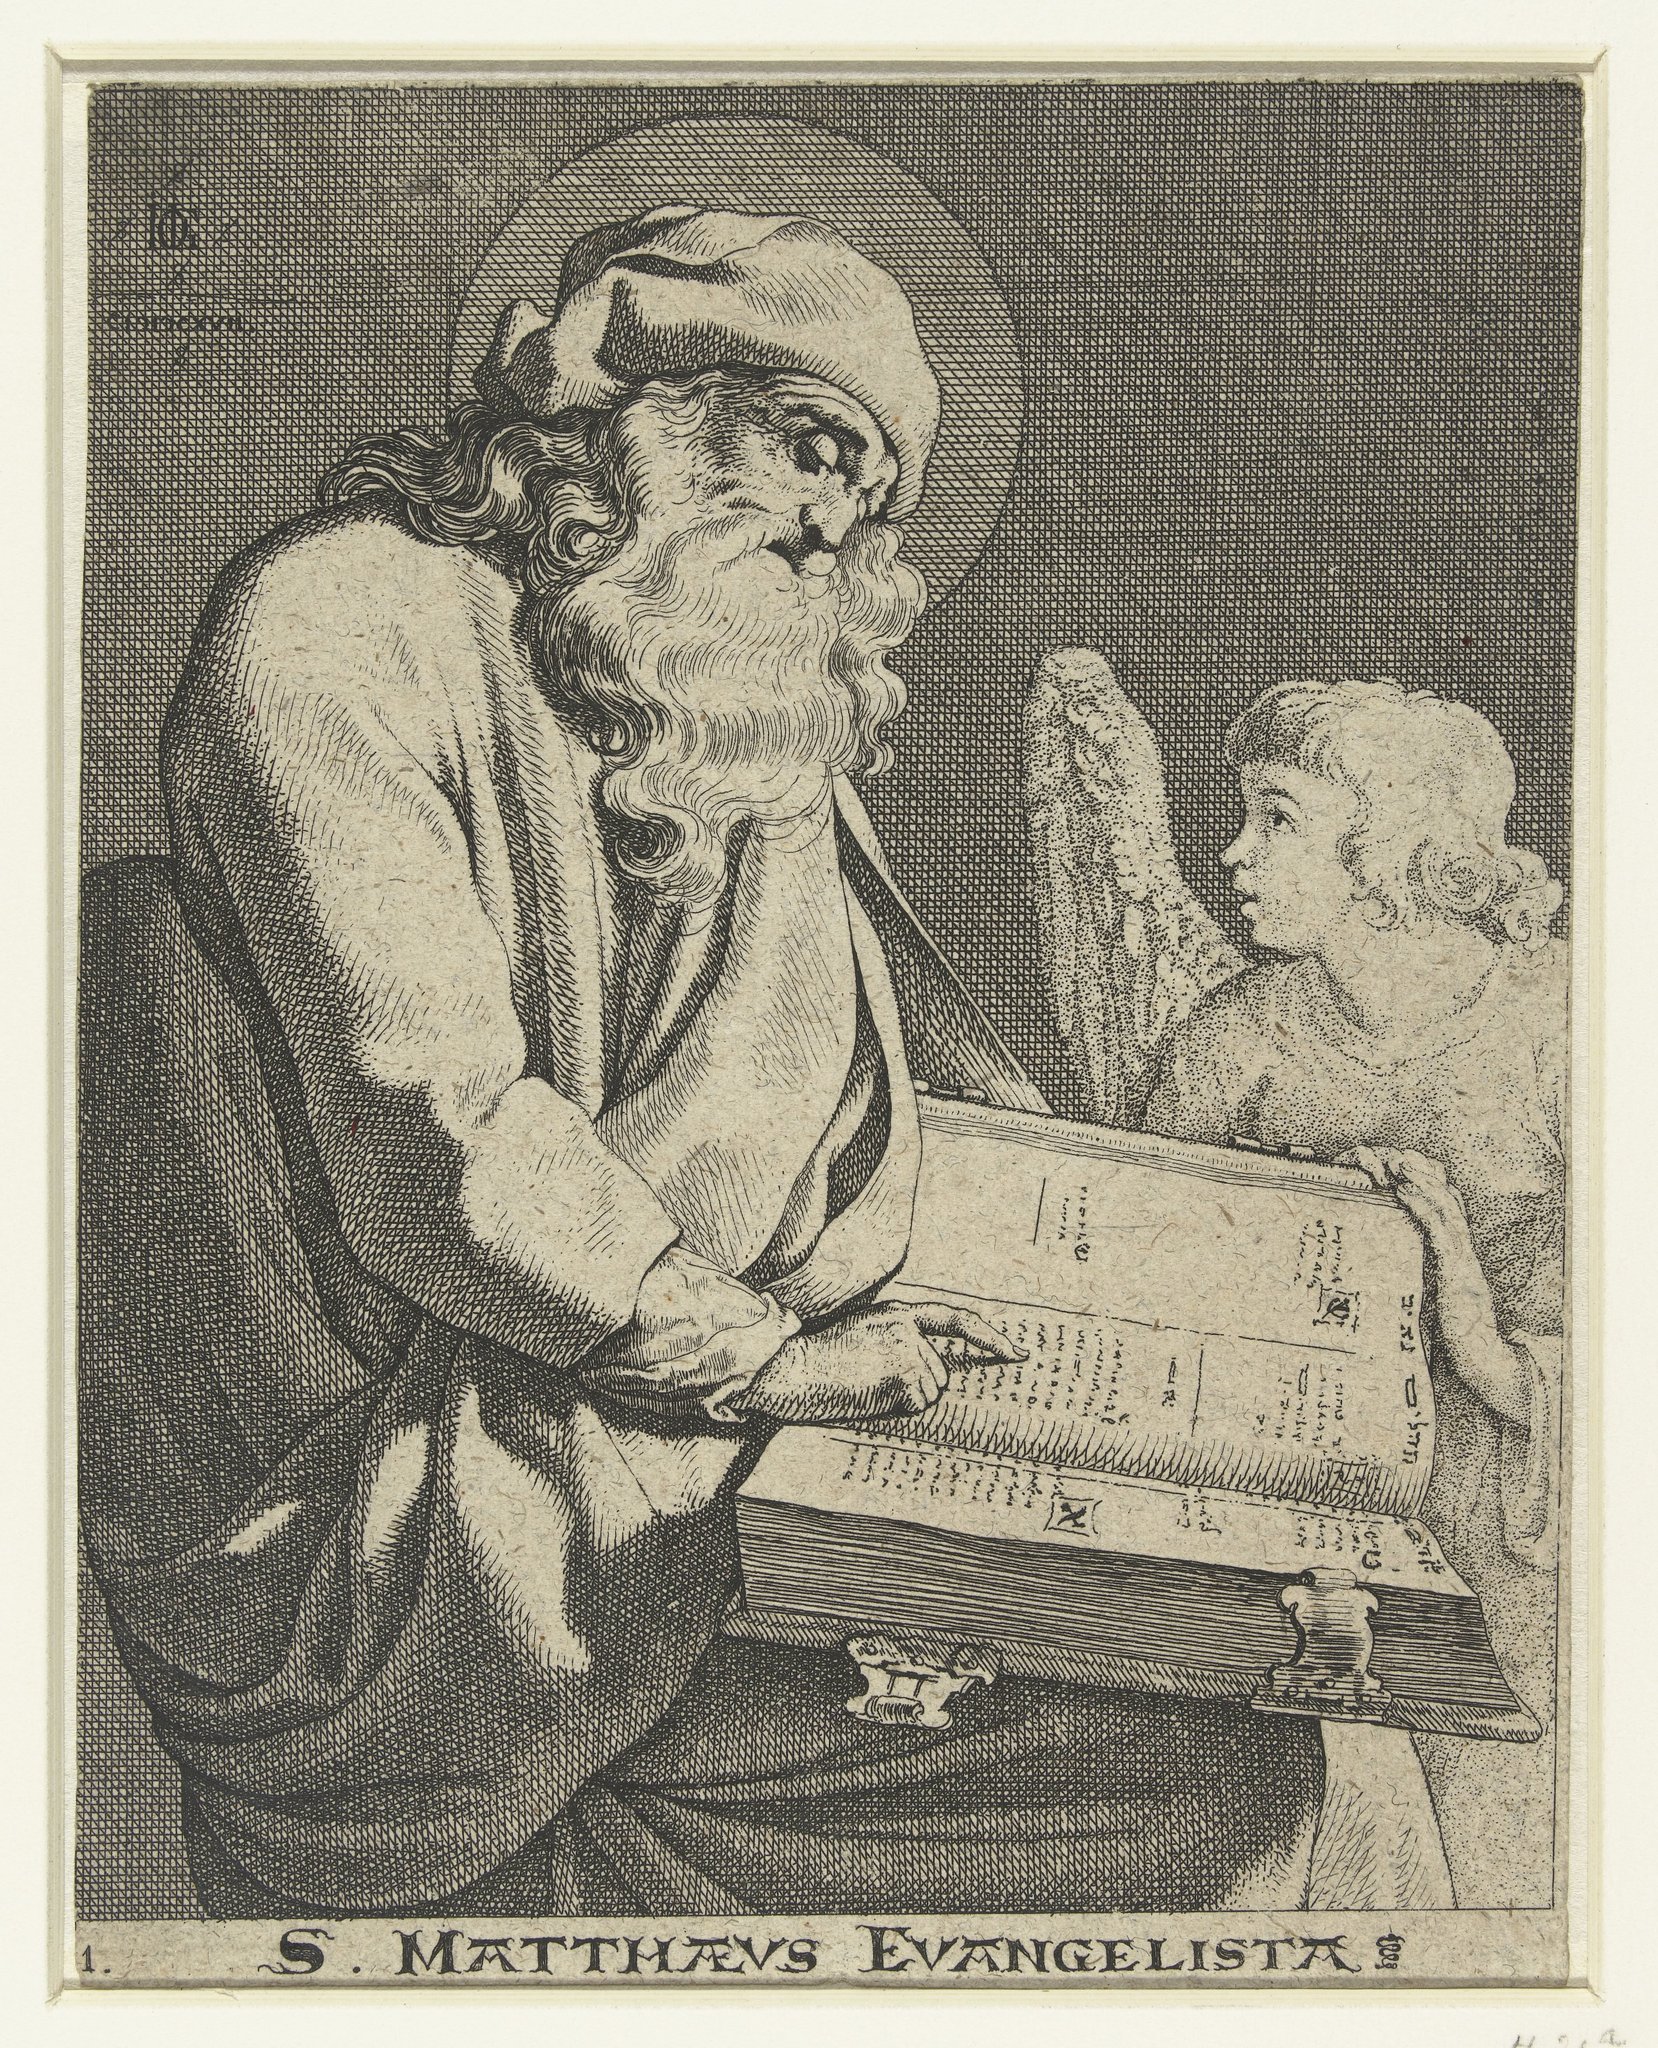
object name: print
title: Evangelist Mattheüs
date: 1617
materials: paper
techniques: etching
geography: delft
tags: the apostle and evangelist matthew (mattheus); possible attributes: angel, axe, book, halberd, pen and inkhorn, purse, scroll, square, sword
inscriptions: collector's mark: Lugt 2228a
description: De evangelist Mattheüs, ten halven lijve, op de rechterzijde gezien, lezend in een boek, een engel aan zijn linkerzijde. Onder de voorstelling een onderschrift: '1. S. Matthaevs Evangelista'.